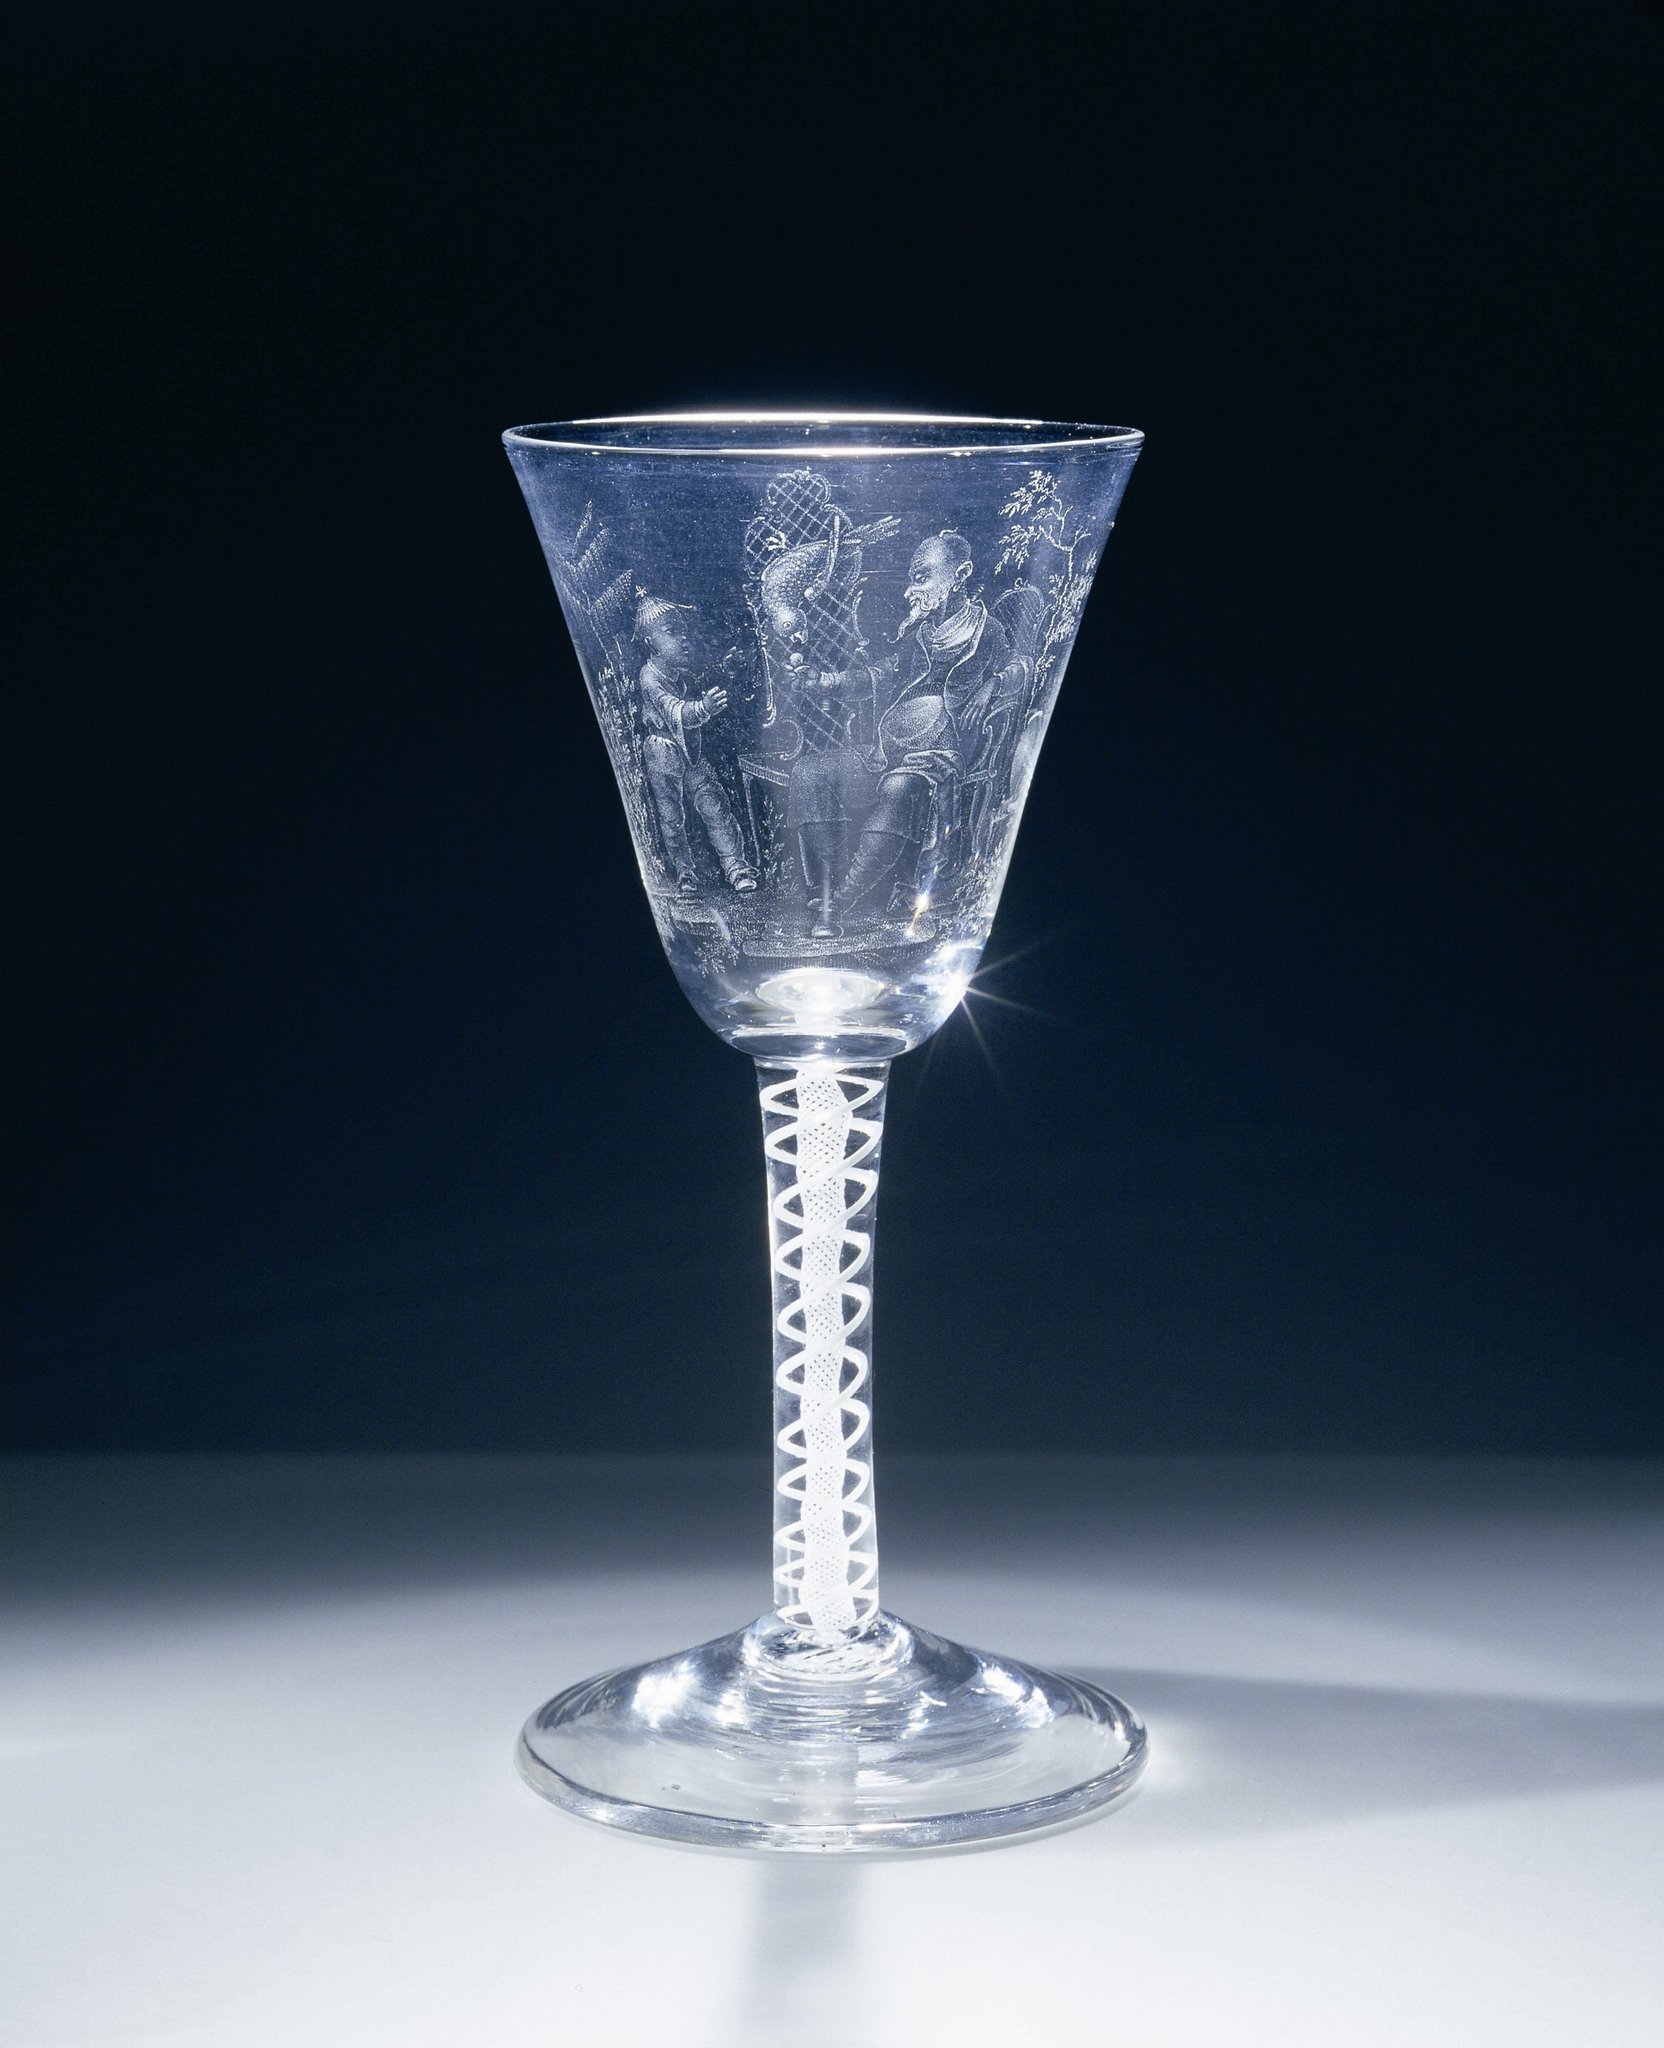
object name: slingerglas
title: Slingerglas met twee Chinezen met een papegaai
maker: meester alius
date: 1760-1780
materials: glass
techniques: glassblowing, engraving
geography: the hague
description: Two Chinamen and a parrot, c. 1760 - 1780.